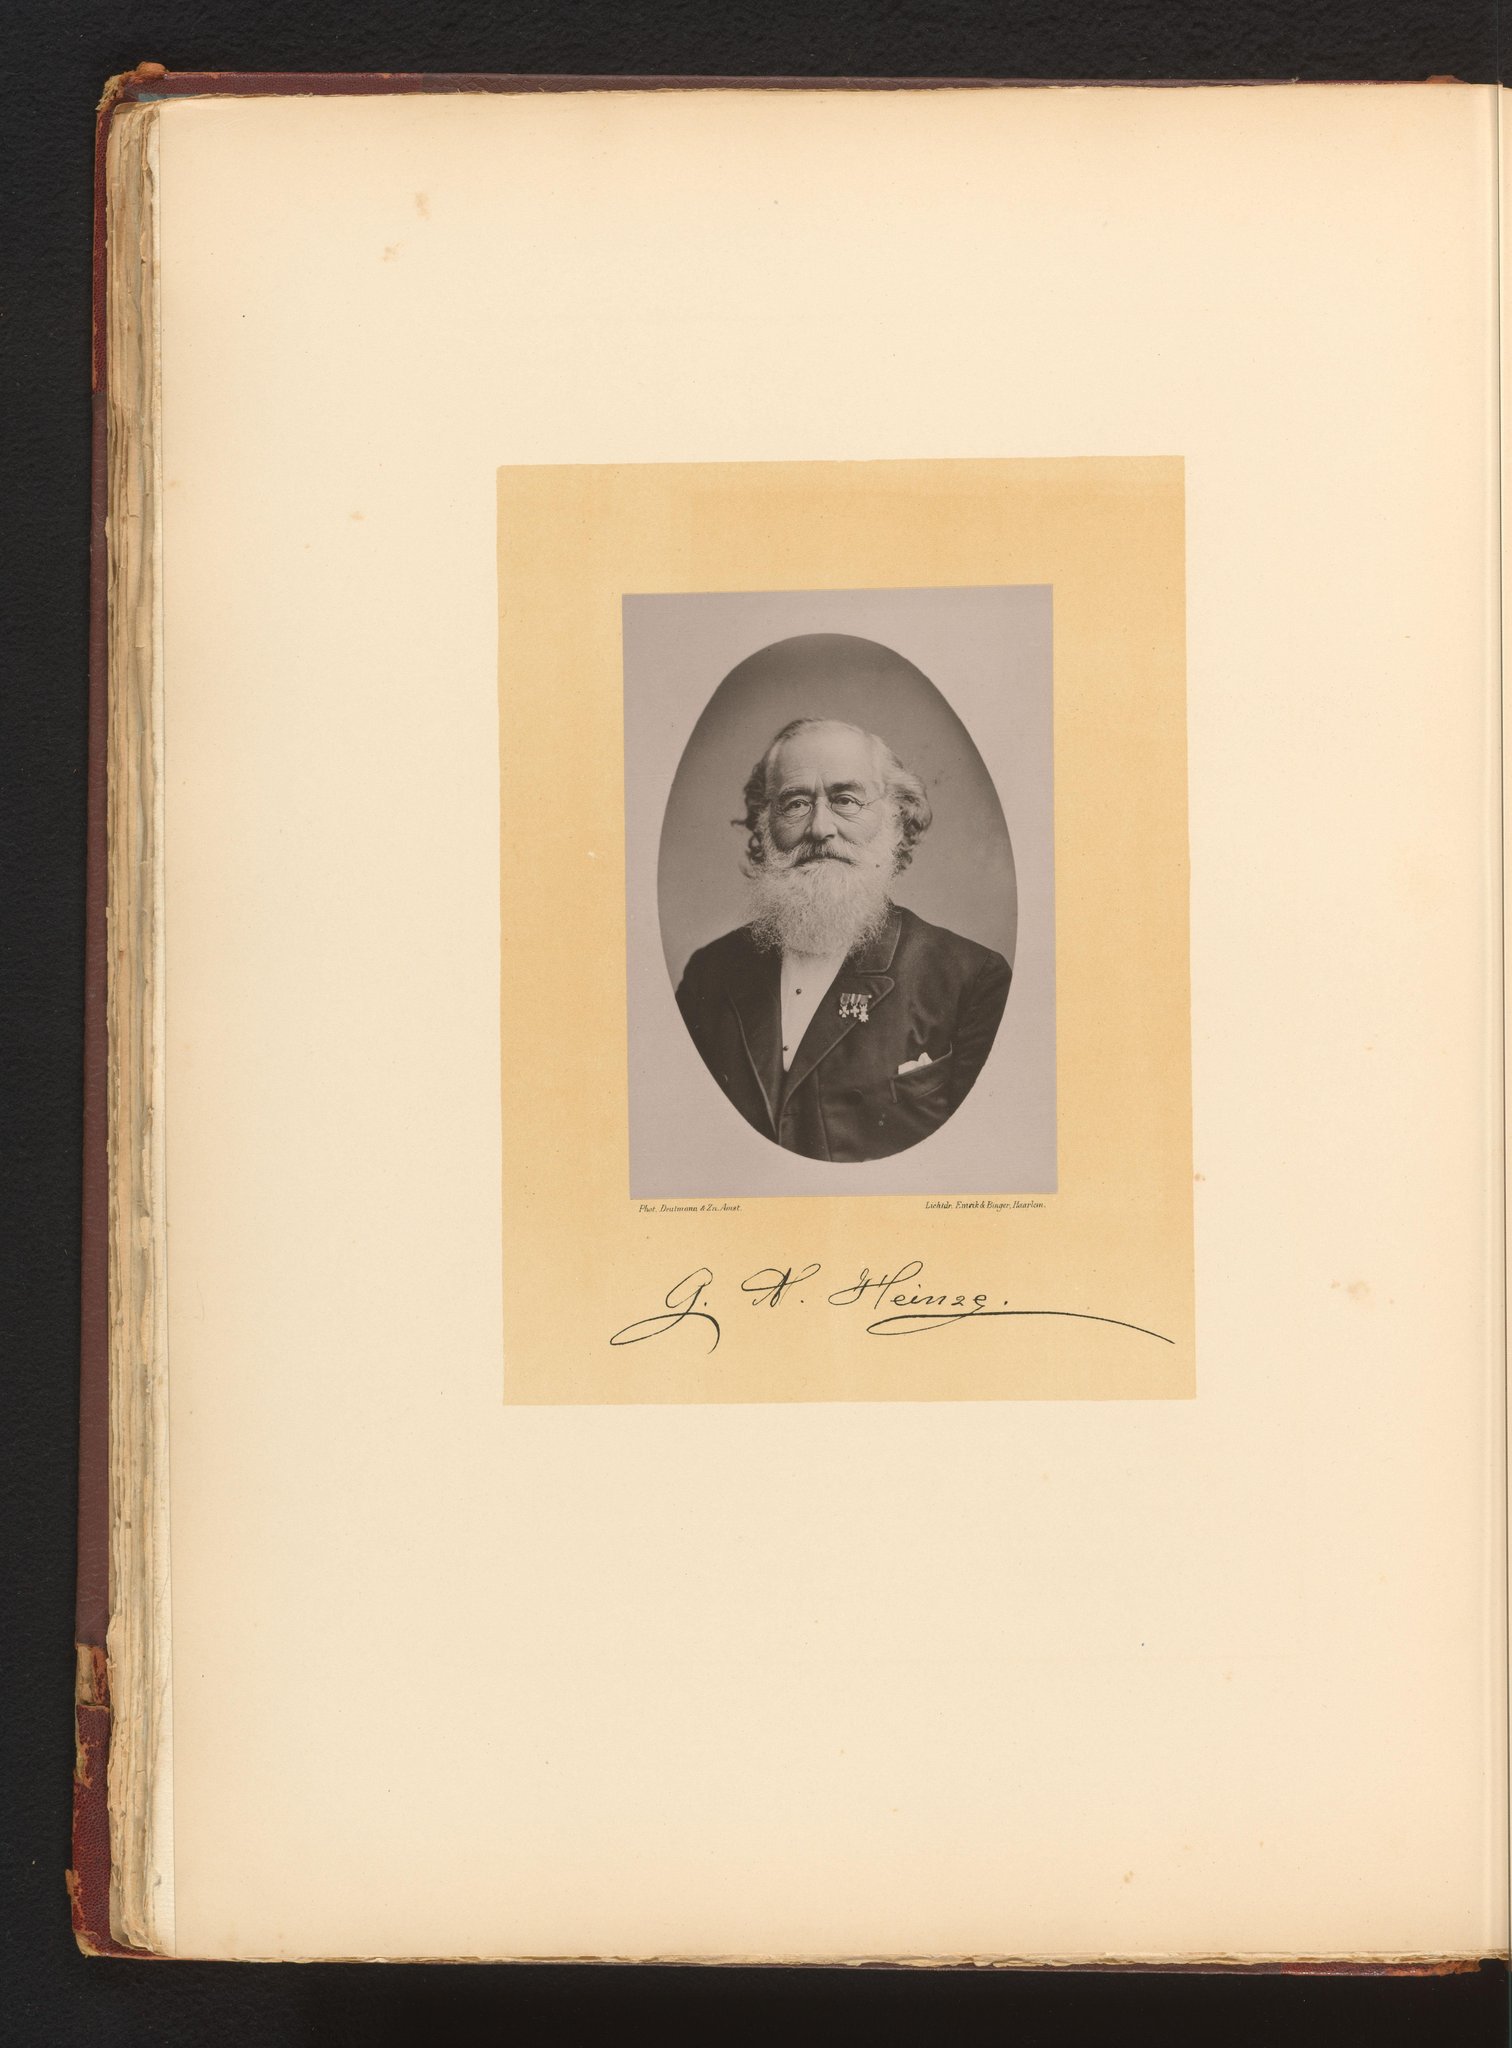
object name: page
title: Portret van Gustav Adolf Heinze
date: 1888-1896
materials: paper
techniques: photograph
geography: haarlem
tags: historical persons, portrait of a musician